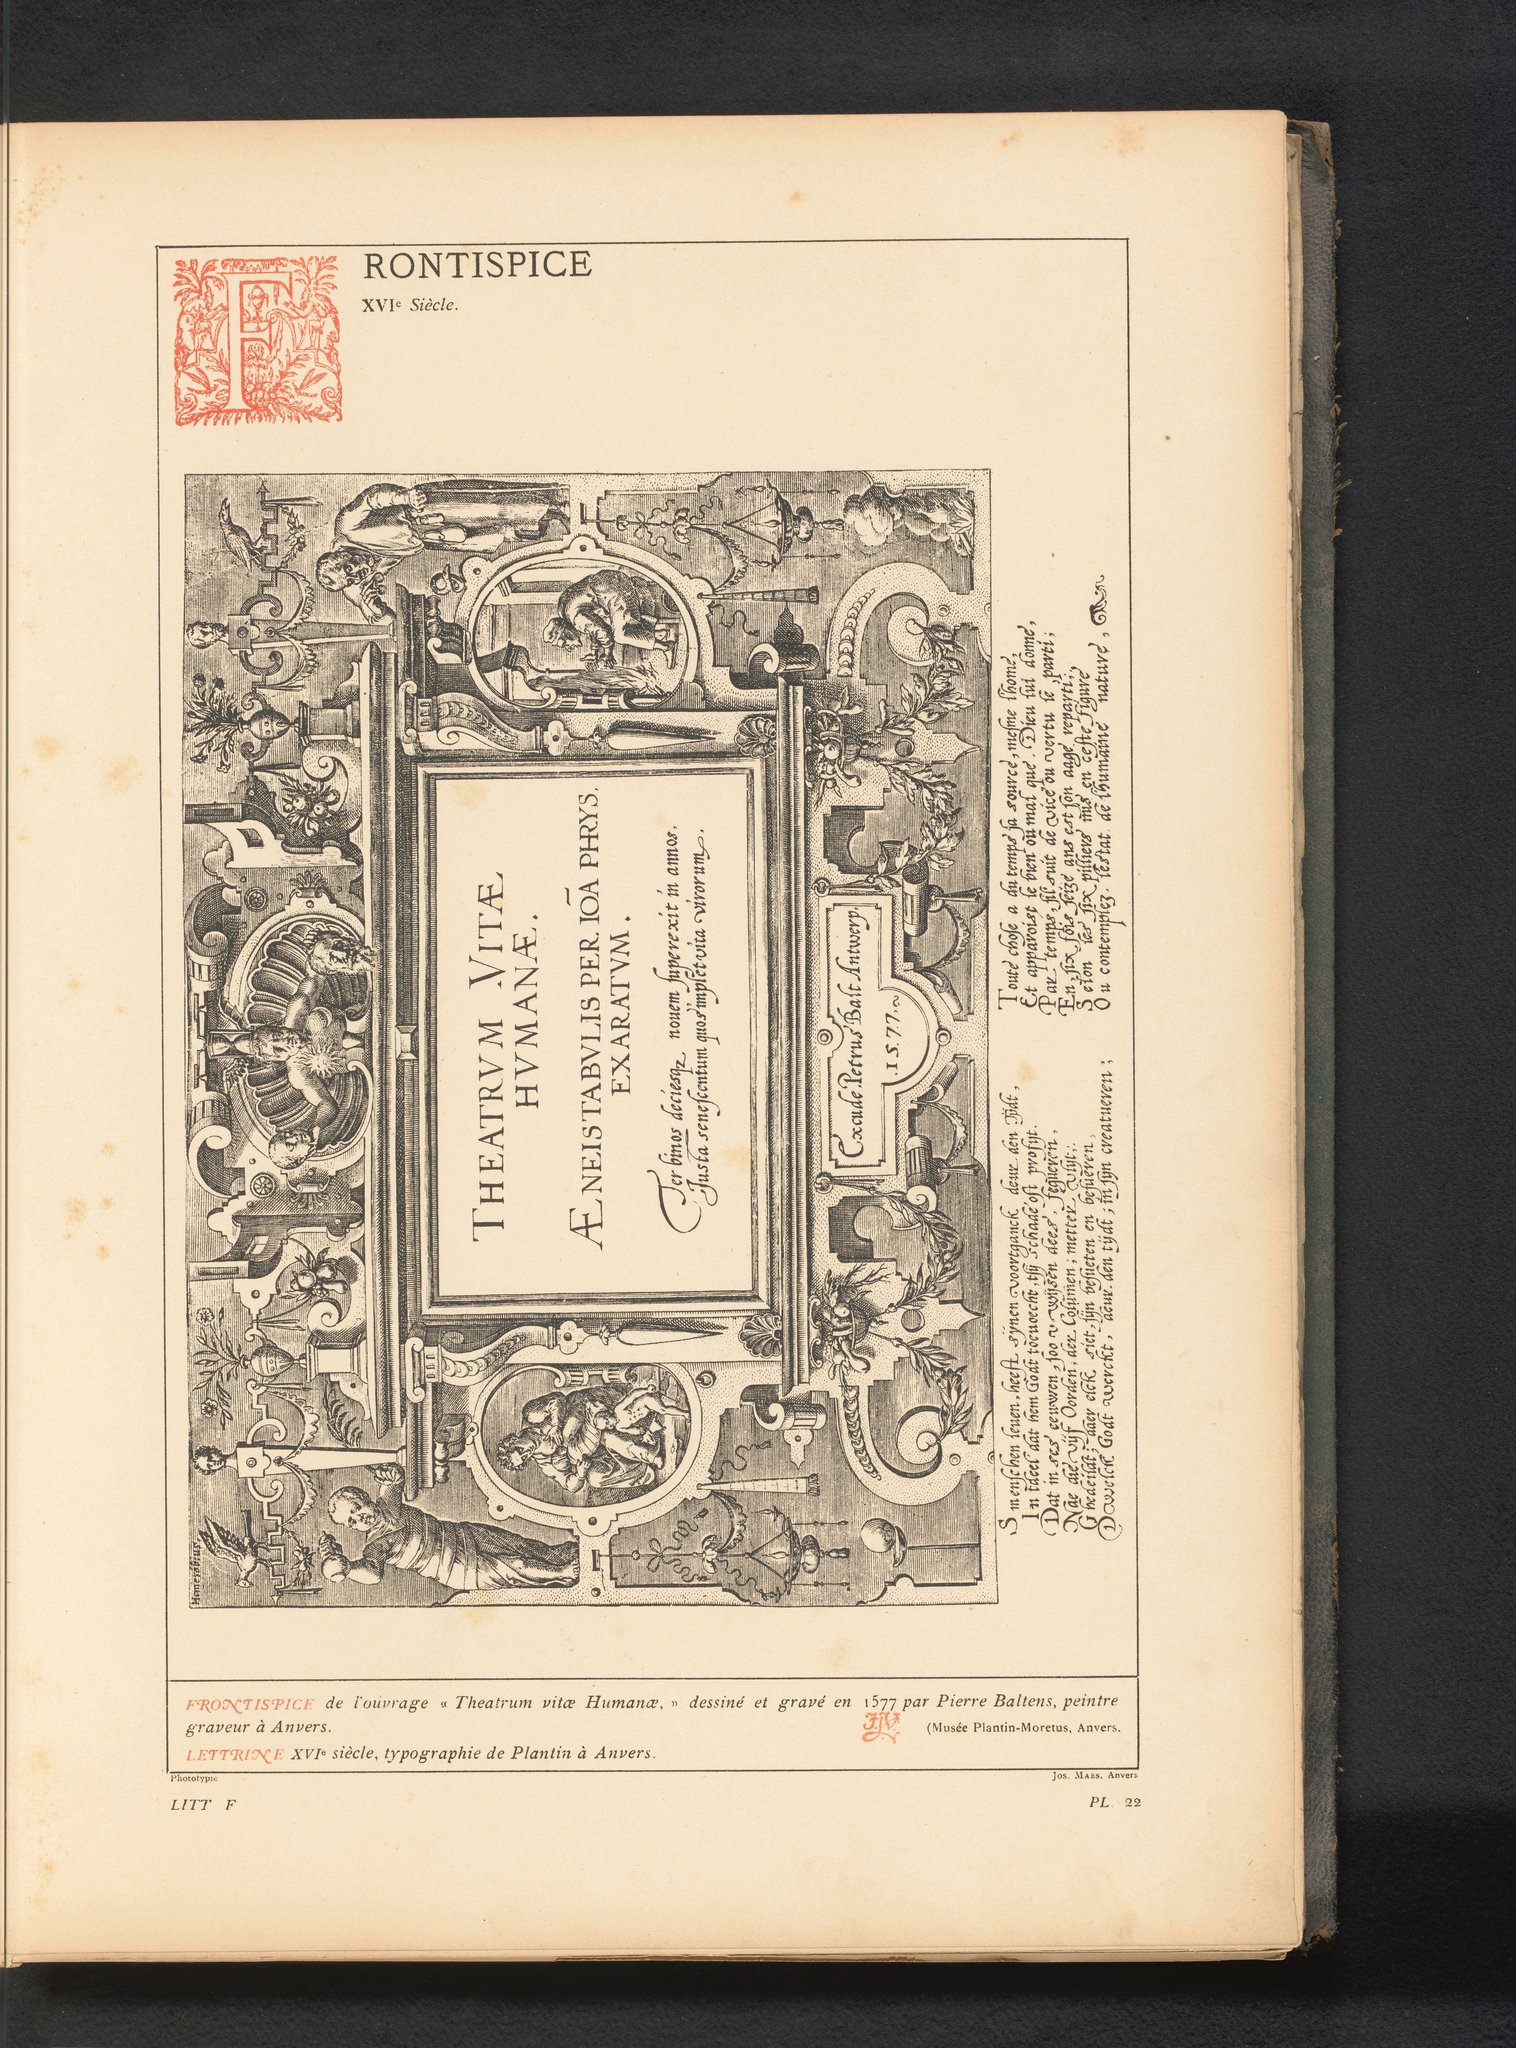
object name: photomechanical print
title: Frontispice, XVIe Siècle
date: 1875-1880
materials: paper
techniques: photolithography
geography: antwerp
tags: ornament ~ grotesque, title-page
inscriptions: inscription: ‘FRONTISPICE de l'ouvrage (...)’, inscription: ‘LITT. F. - PL. 22’, monogram: ‘JJvY’